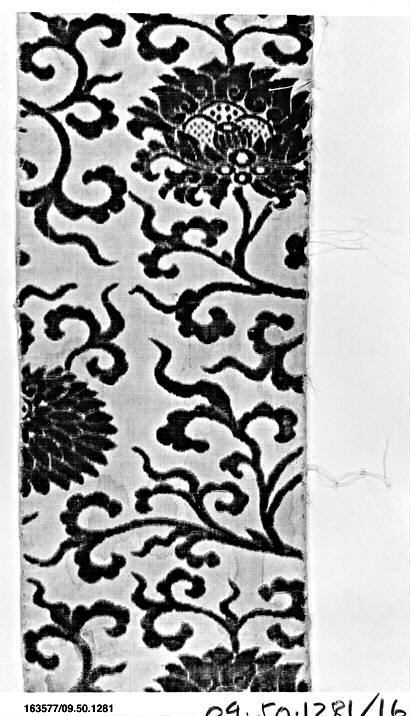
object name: piece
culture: chinese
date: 1701-1800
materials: silk